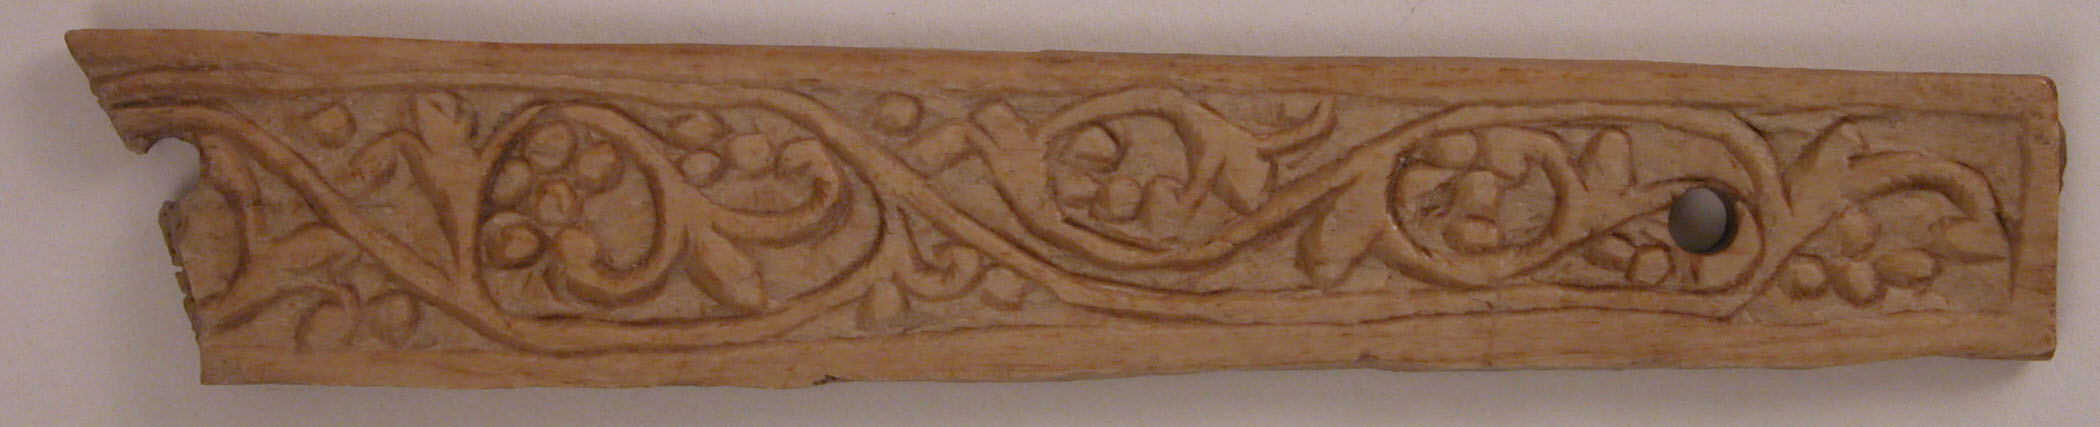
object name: plaque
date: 601-800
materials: bone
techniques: carving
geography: egypt